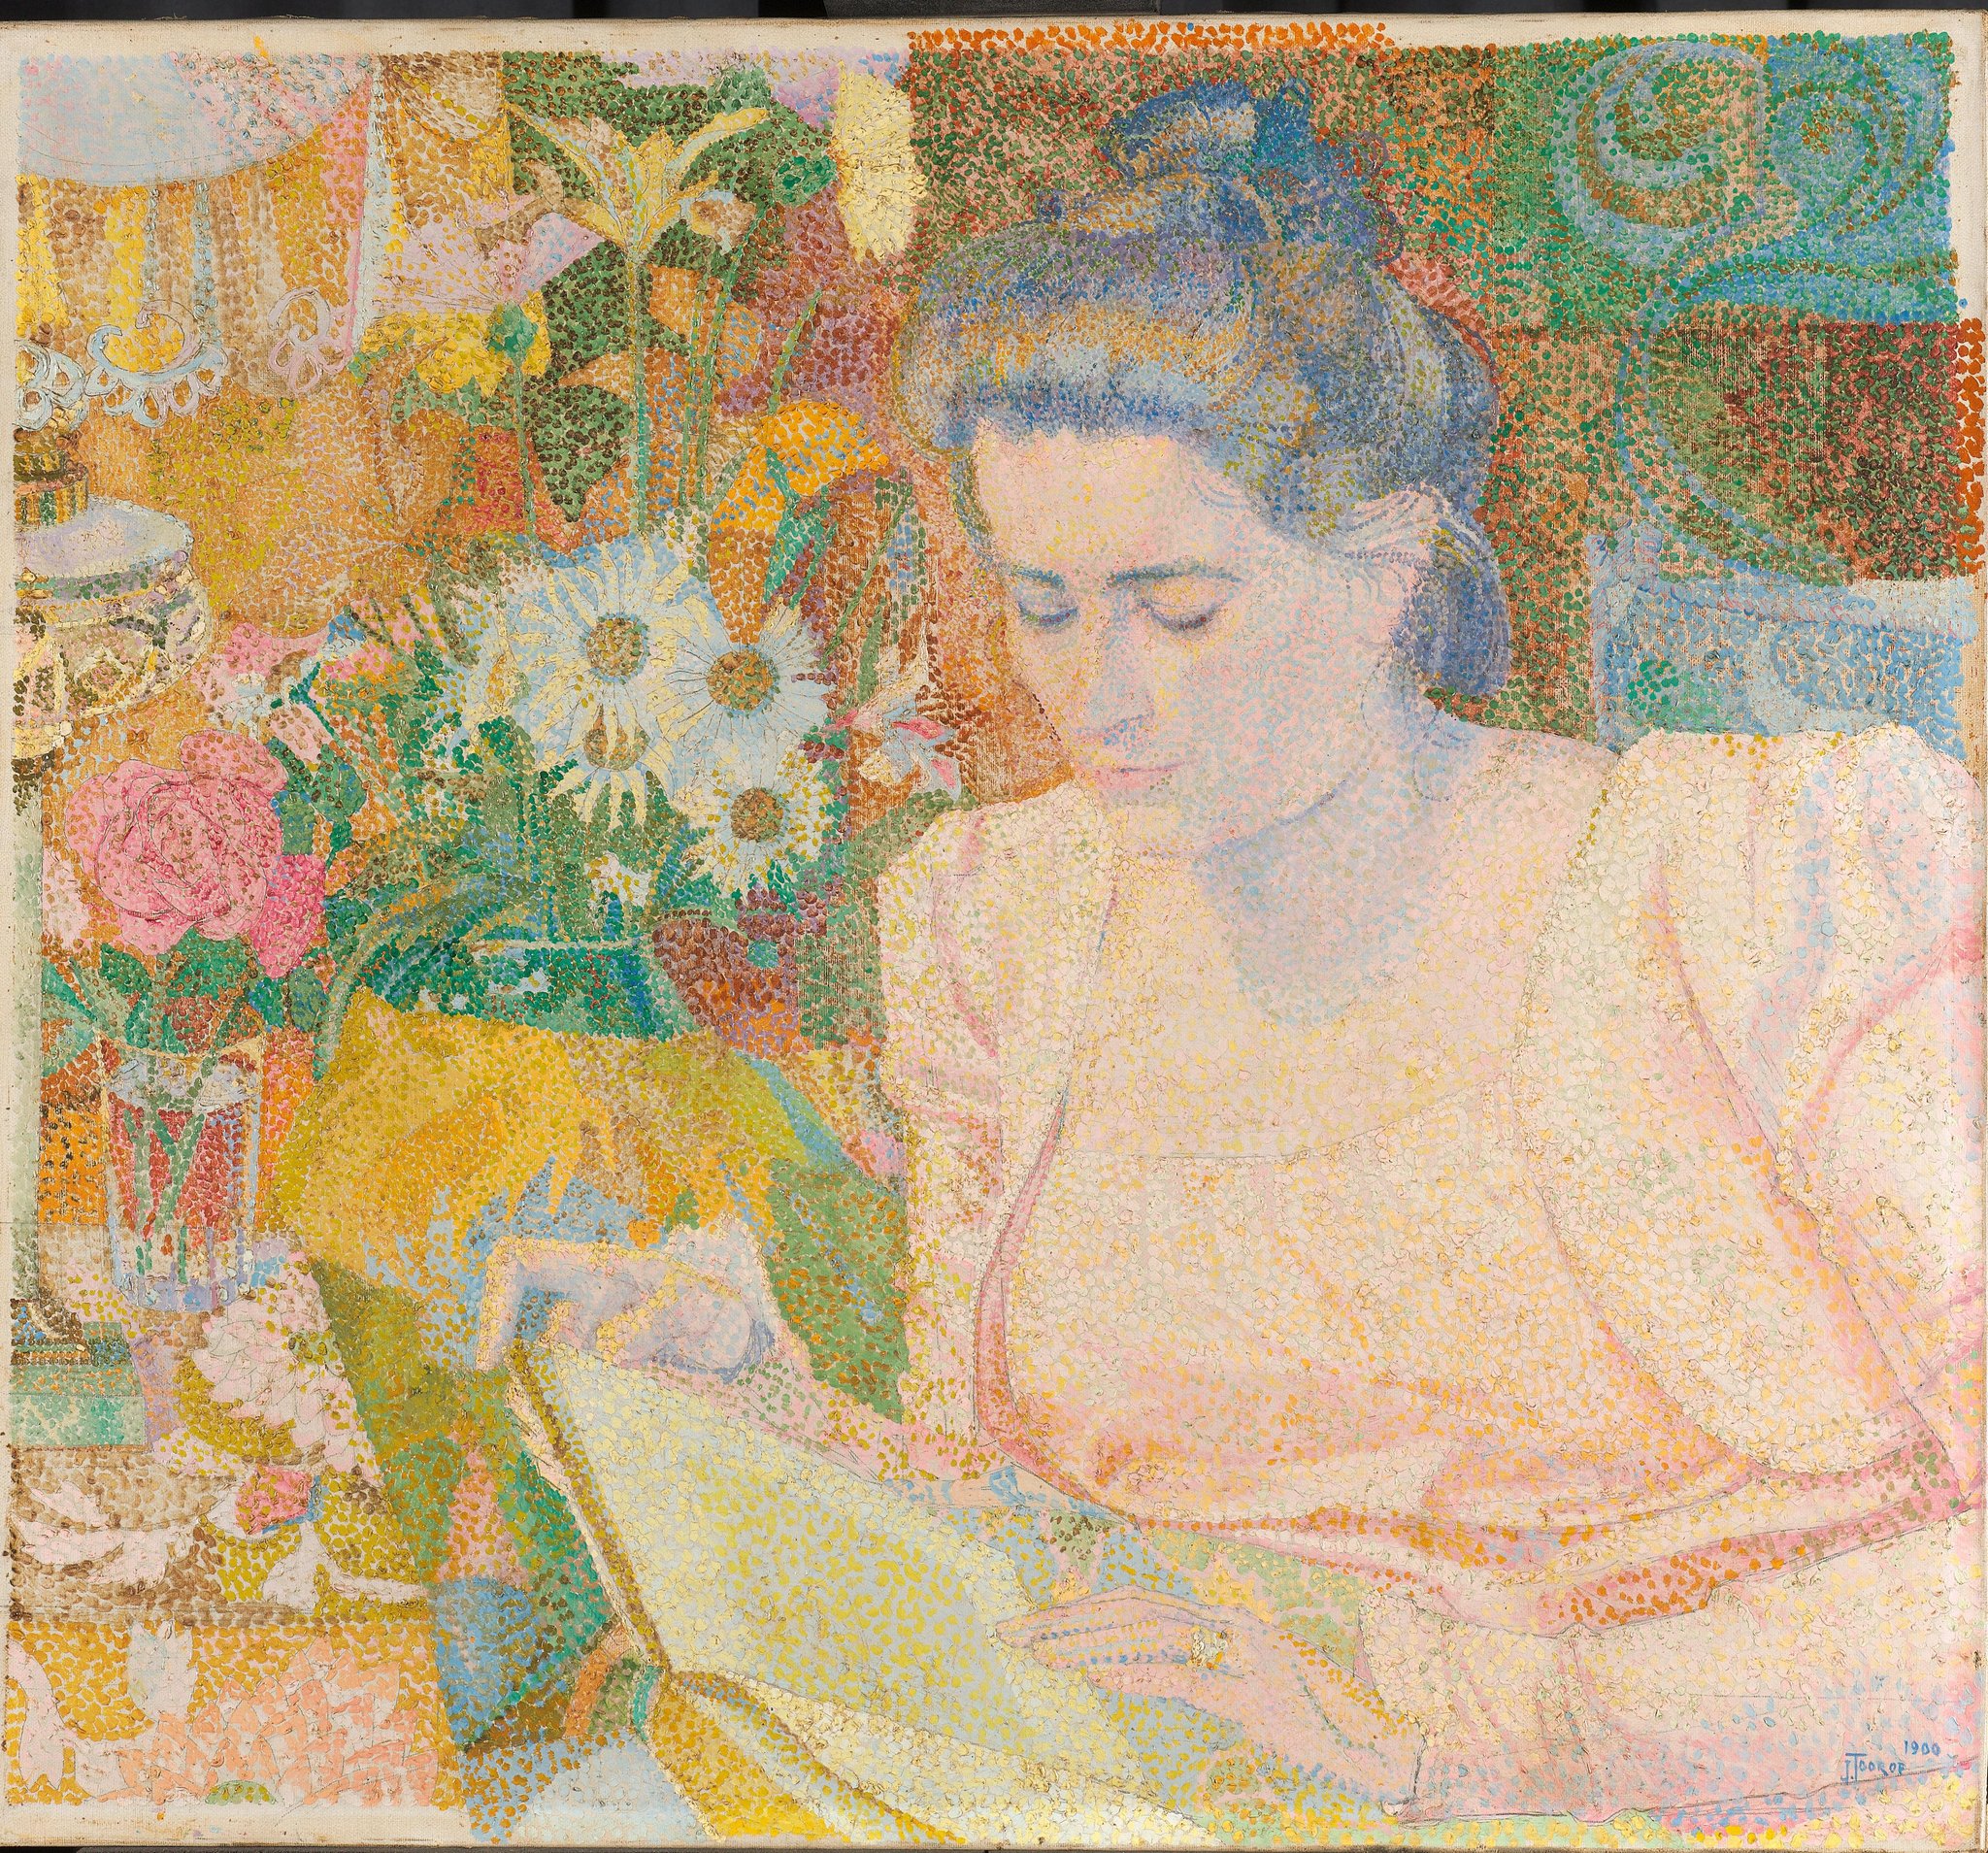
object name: painting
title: Portrait of Marie Jeanette de Lange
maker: jan toorop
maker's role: draughtsman, painter, print maker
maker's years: 1858-1928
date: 1900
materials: canvas, oil, paint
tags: jan bouman, marie jeannette de lange, reading, historical persons - bb - woman, flowers in a vase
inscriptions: signature and date: ‘J.Toorop 1900’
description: Marie Jeanette de Lange chaired the Vereeniging voor Verbetering van Vrouwenkleding (Association for the Improvement of Women’s Clothing), which championed hygienic, loose-fitting, natural clothing that allowed women greater freedom of movement. In February 1900 she posed at home, dressed comfortably, for Jan Toorop. Using tiny dots of colourful paint, he created a sparkling portrait of a modern woman on the threshold of a new century.